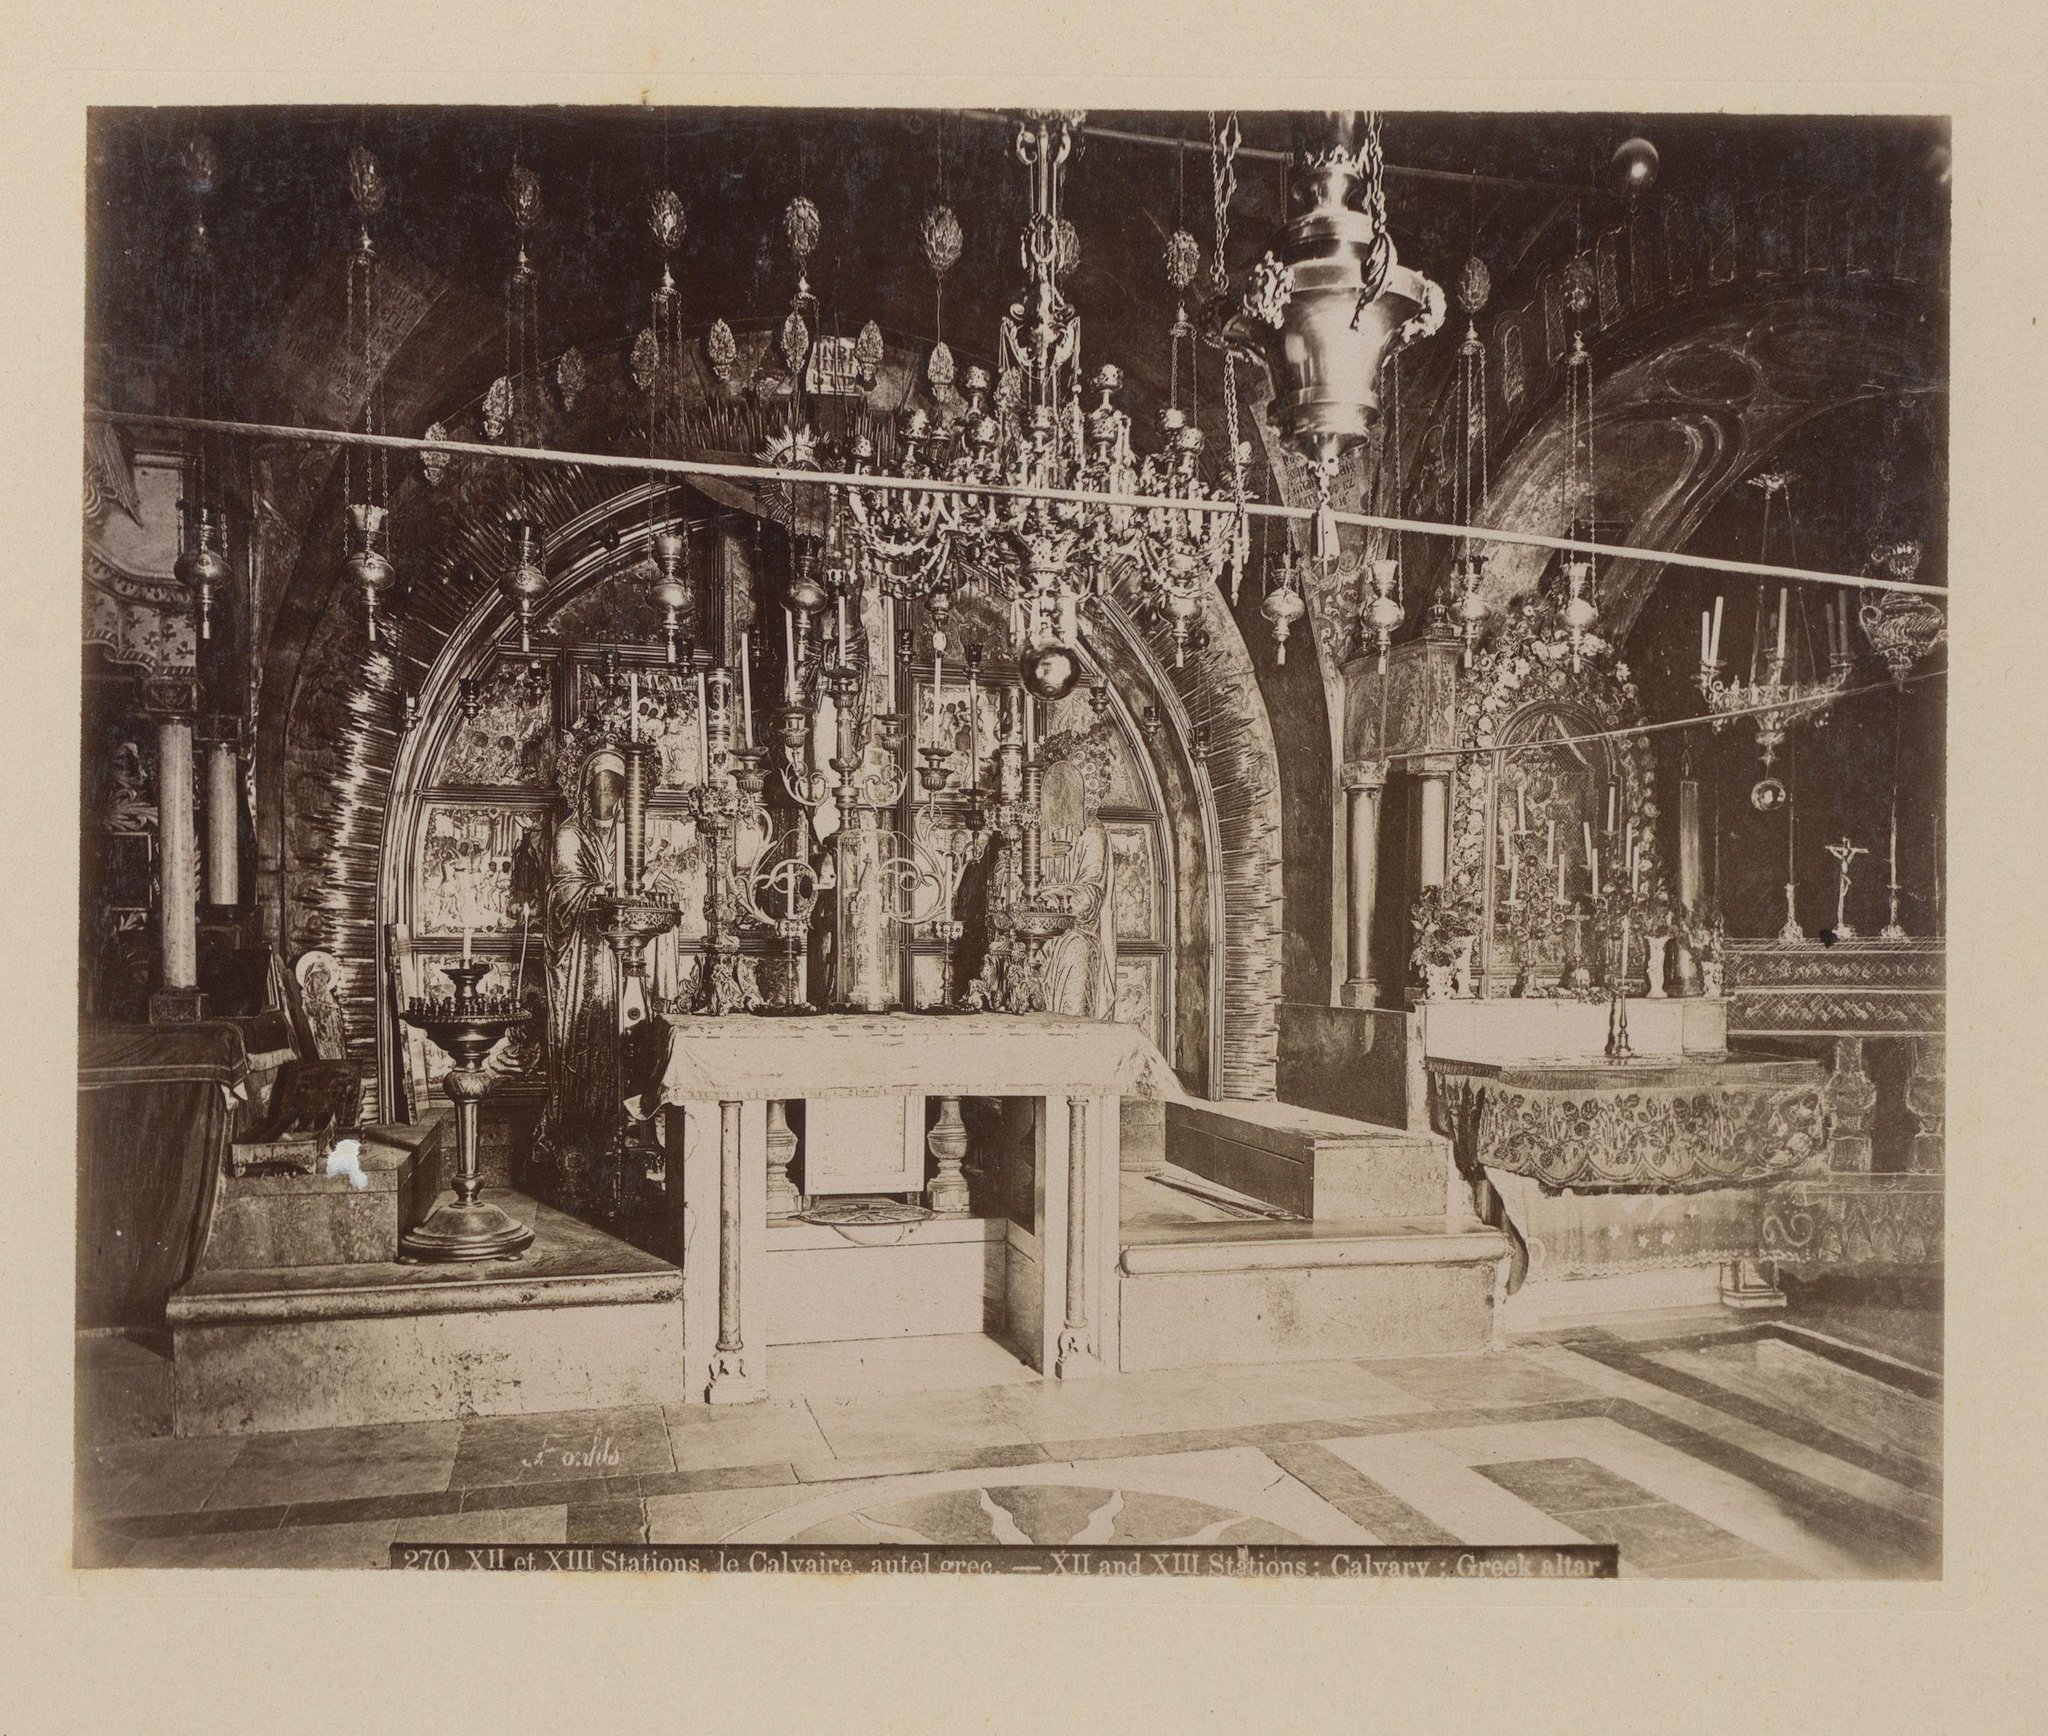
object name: photograph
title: XII et XIII Stations, le calvaire, autel grec / XII and XIII Stations: Calvary: Greek altar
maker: félix bonfils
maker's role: fotograaf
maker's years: 1831-1885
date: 1867-1885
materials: paper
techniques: albumen print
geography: jerusalem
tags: street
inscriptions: number: ‘270’